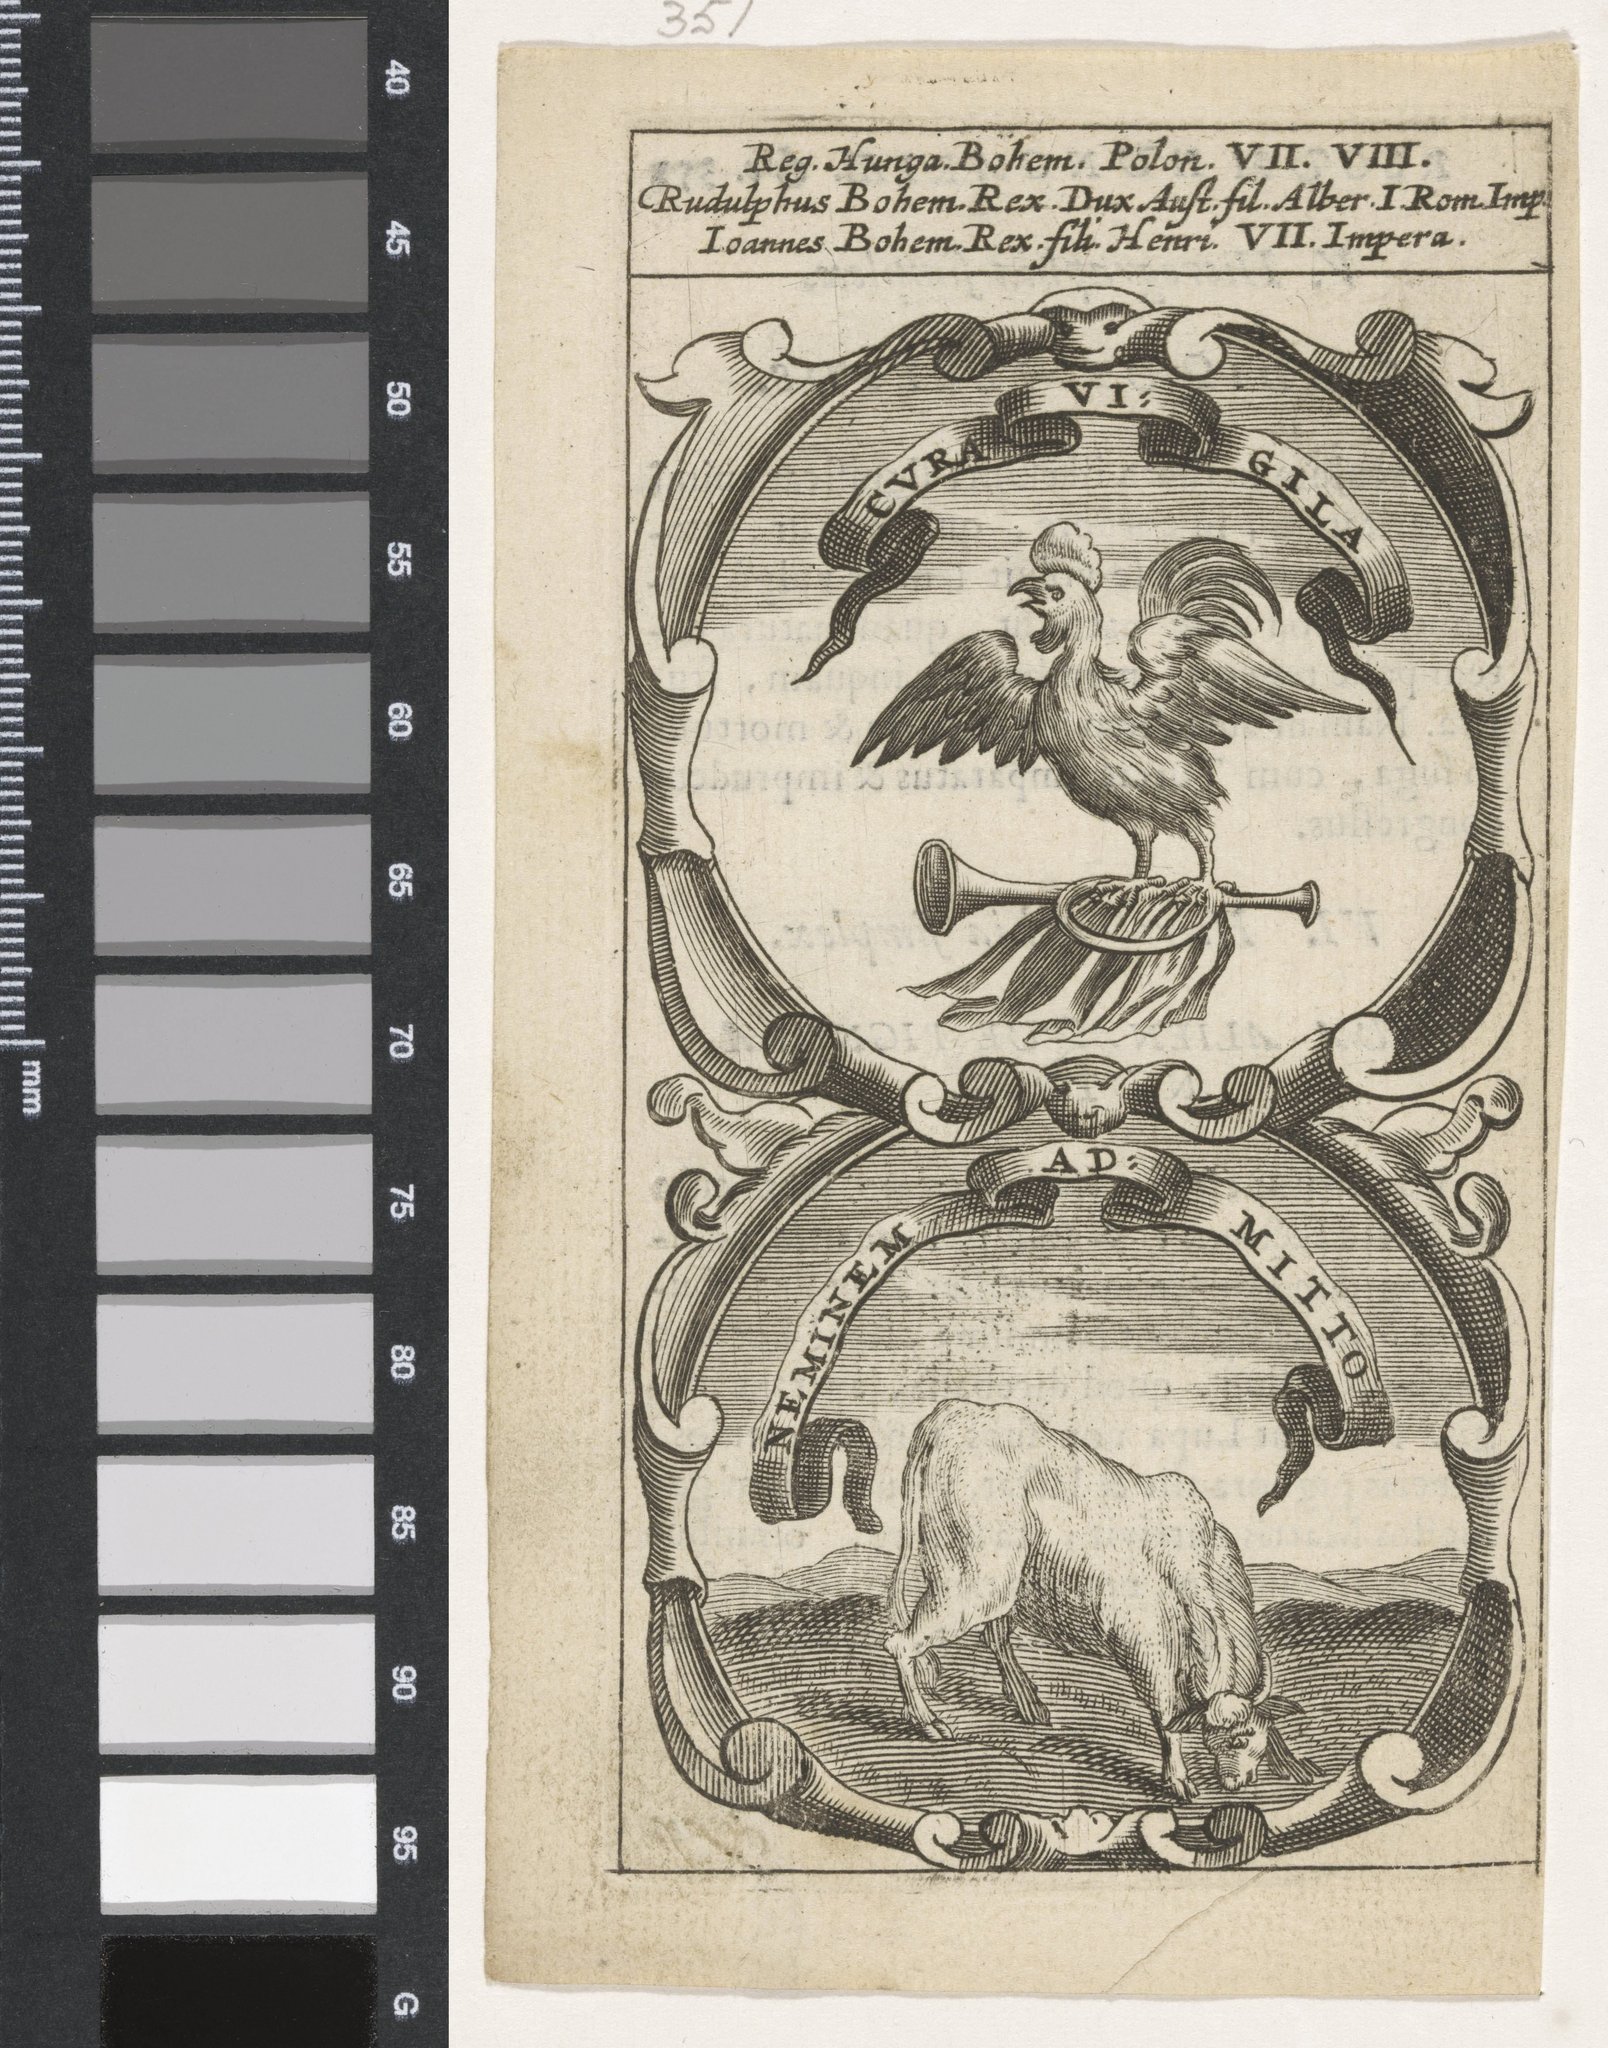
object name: print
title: Symbola Divina et Humana Pontificum Imperatorum Regum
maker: Anonymous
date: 1666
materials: paper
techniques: engraving, letterpress printing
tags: vienna, prague, rudolf ii van habsburg (duits keizer), earl, bull, horn, trumpet, cornet, trombone, tuba, fowl (cock, hen, chicken, etc.)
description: Pagina uit Jacob Typotius, Symbola Divina & Humana Pontificum Imperatorum Regum. Arnhem, J.F. Hagen, 1666 of uit de titeluitgave van 1669 of 1679. Het werk van Typotius werd voor het eerst uitgegeven in 1601 met prenten van Aegidius Sadeler.